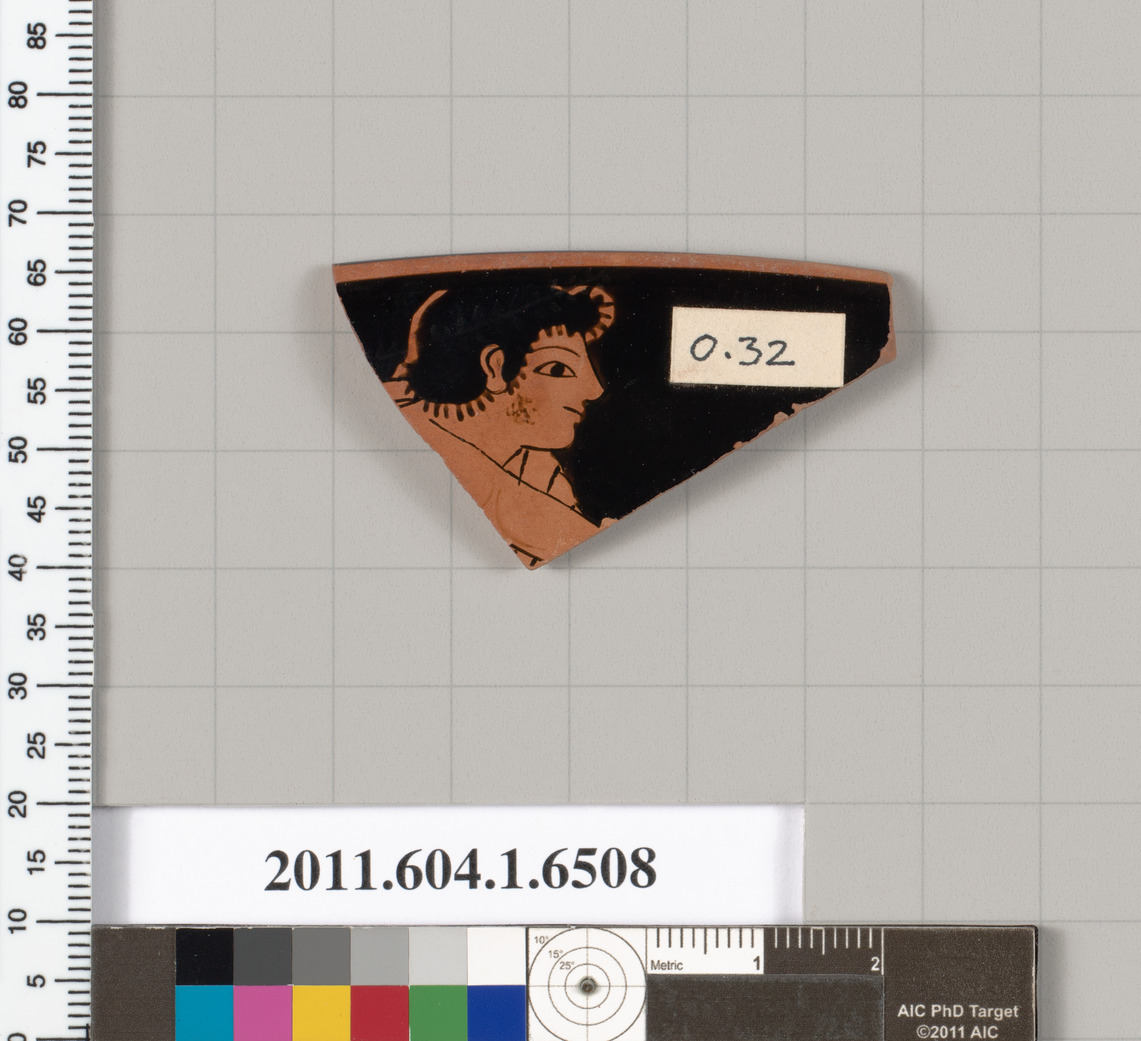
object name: kylix fragment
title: Terracotta rim fragment of a kylix (drinking cup)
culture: greek, attic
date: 490-480 BCE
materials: terracotta